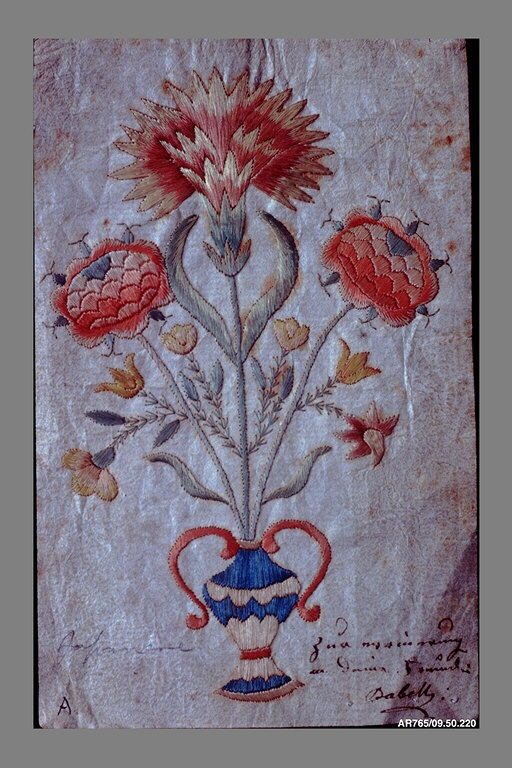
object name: pattern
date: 1701-1800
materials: paper, silk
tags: flowers